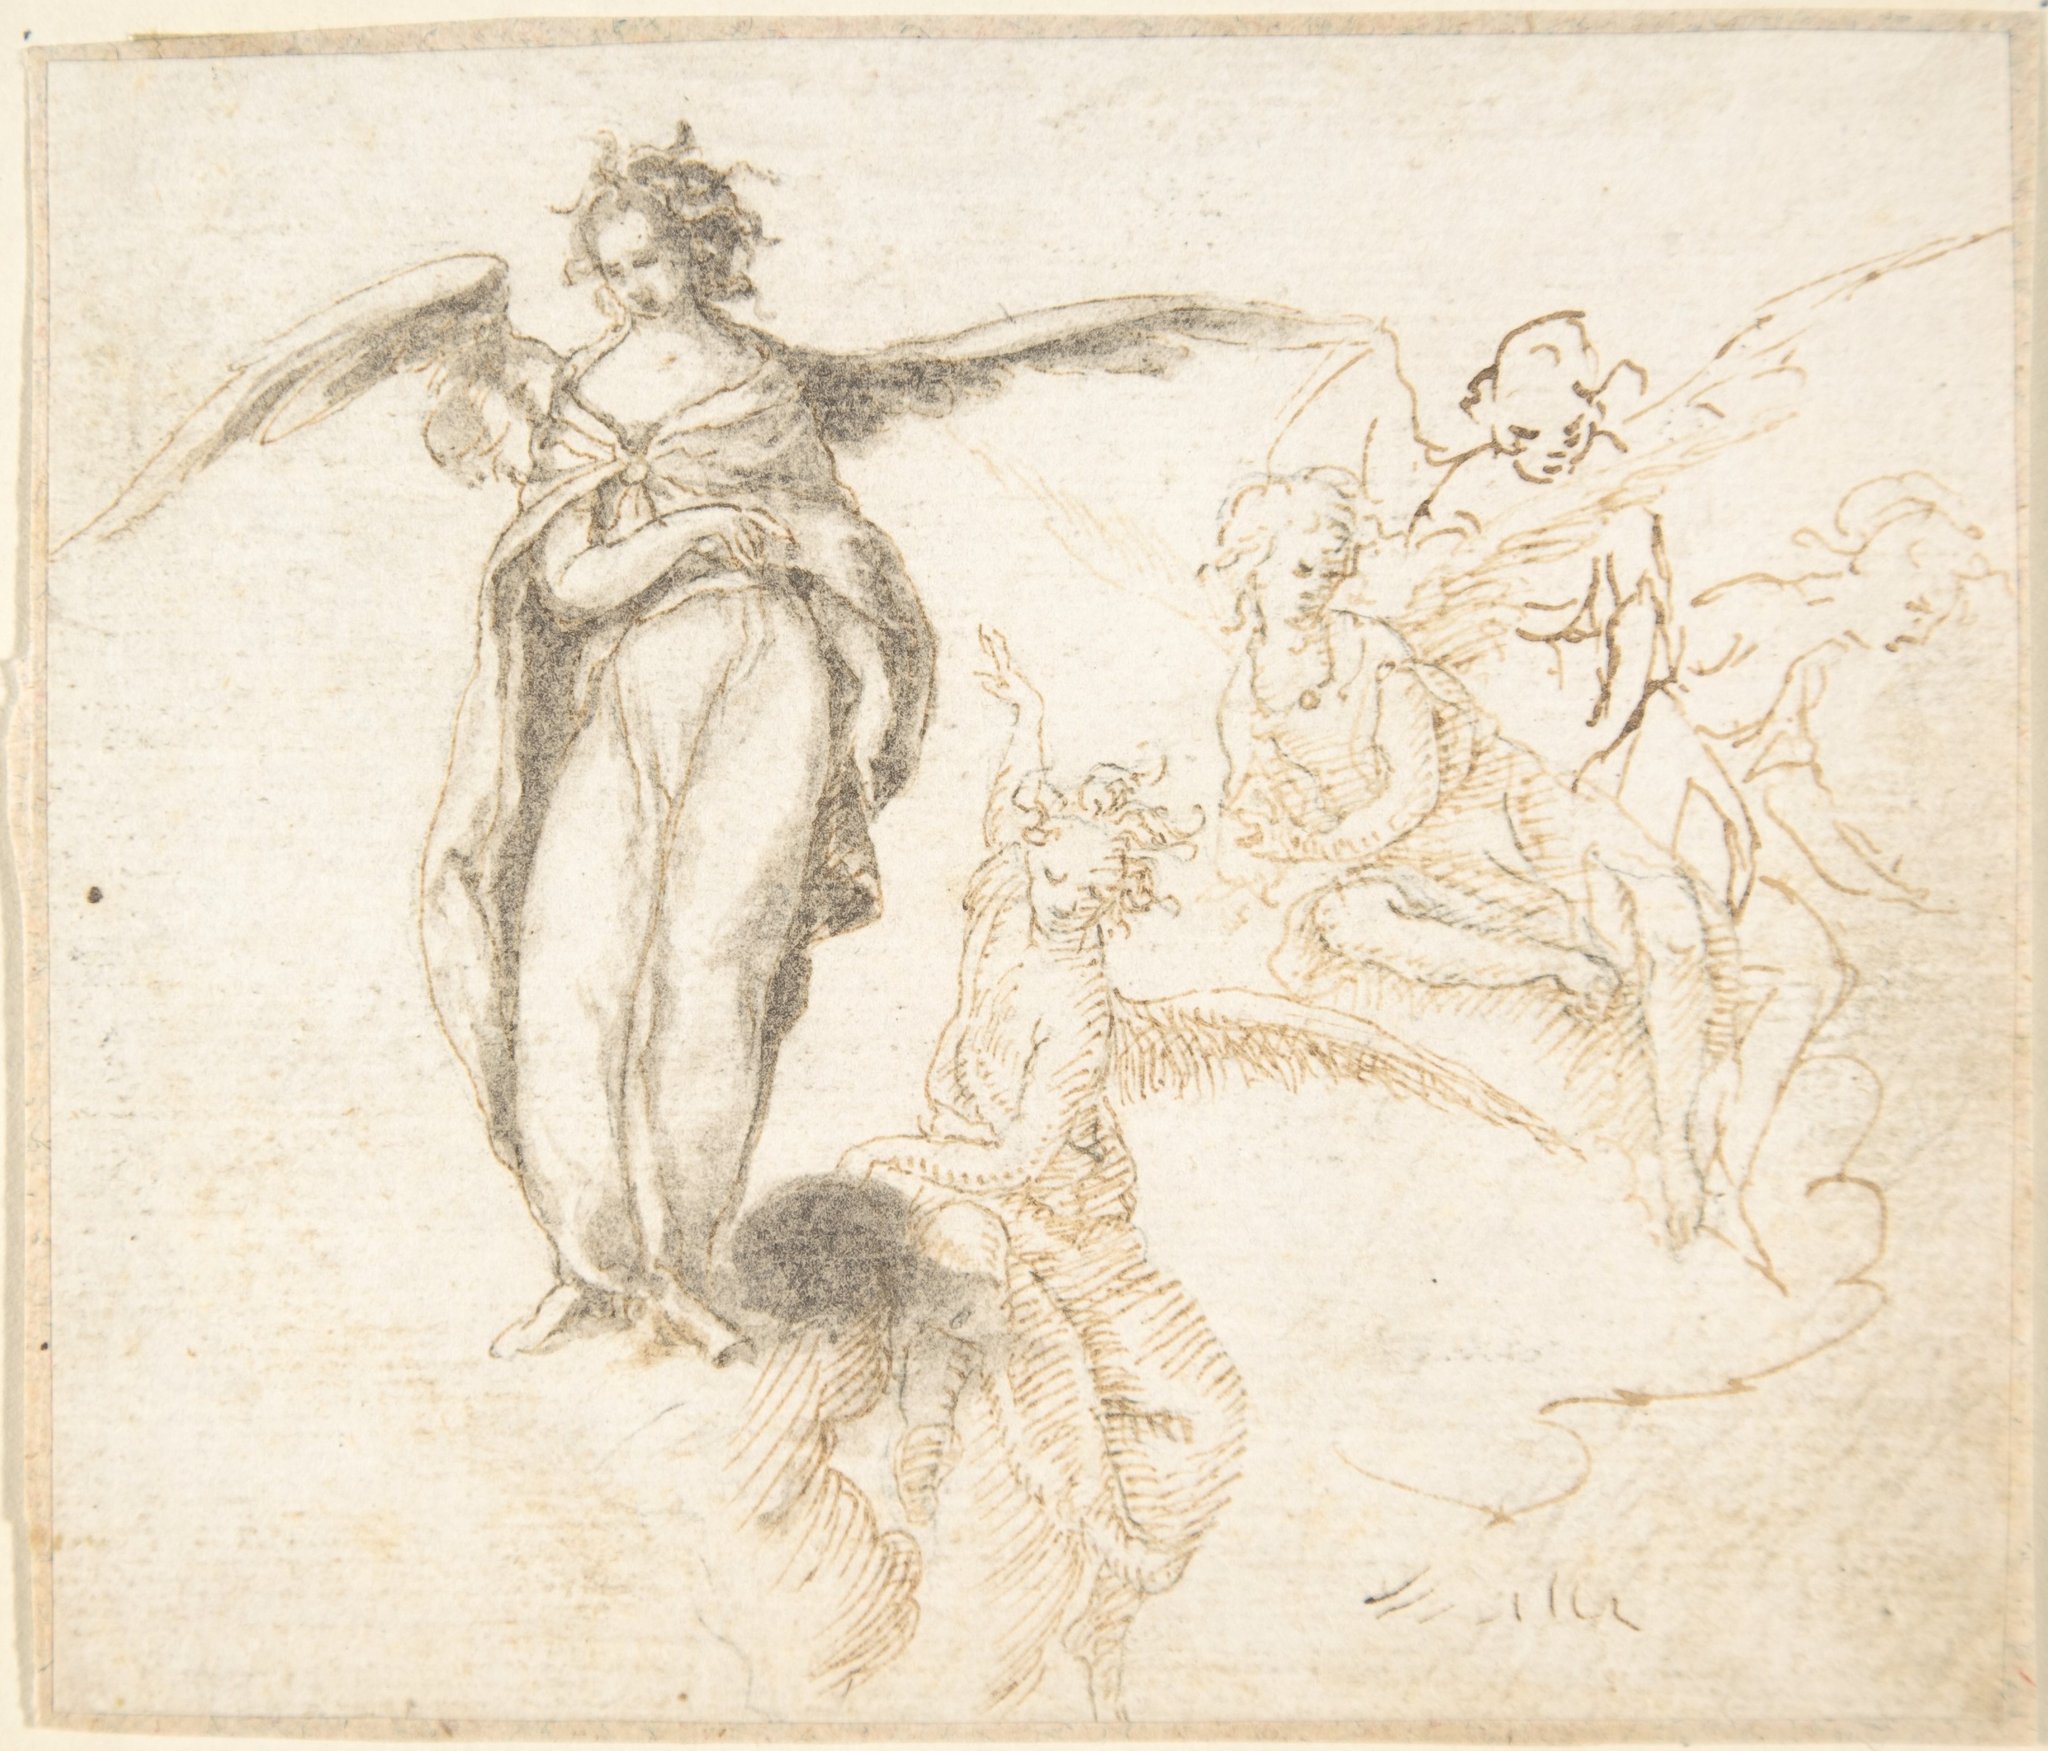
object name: drawing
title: Studies for Five Figures of Angels Standing, and Seated on Clouds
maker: anonymous, spanish, school of seville, 17th century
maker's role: artist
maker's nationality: spanish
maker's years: 1600-1700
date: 1601-1700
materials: chalk, ink, paper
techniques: pen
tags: angels